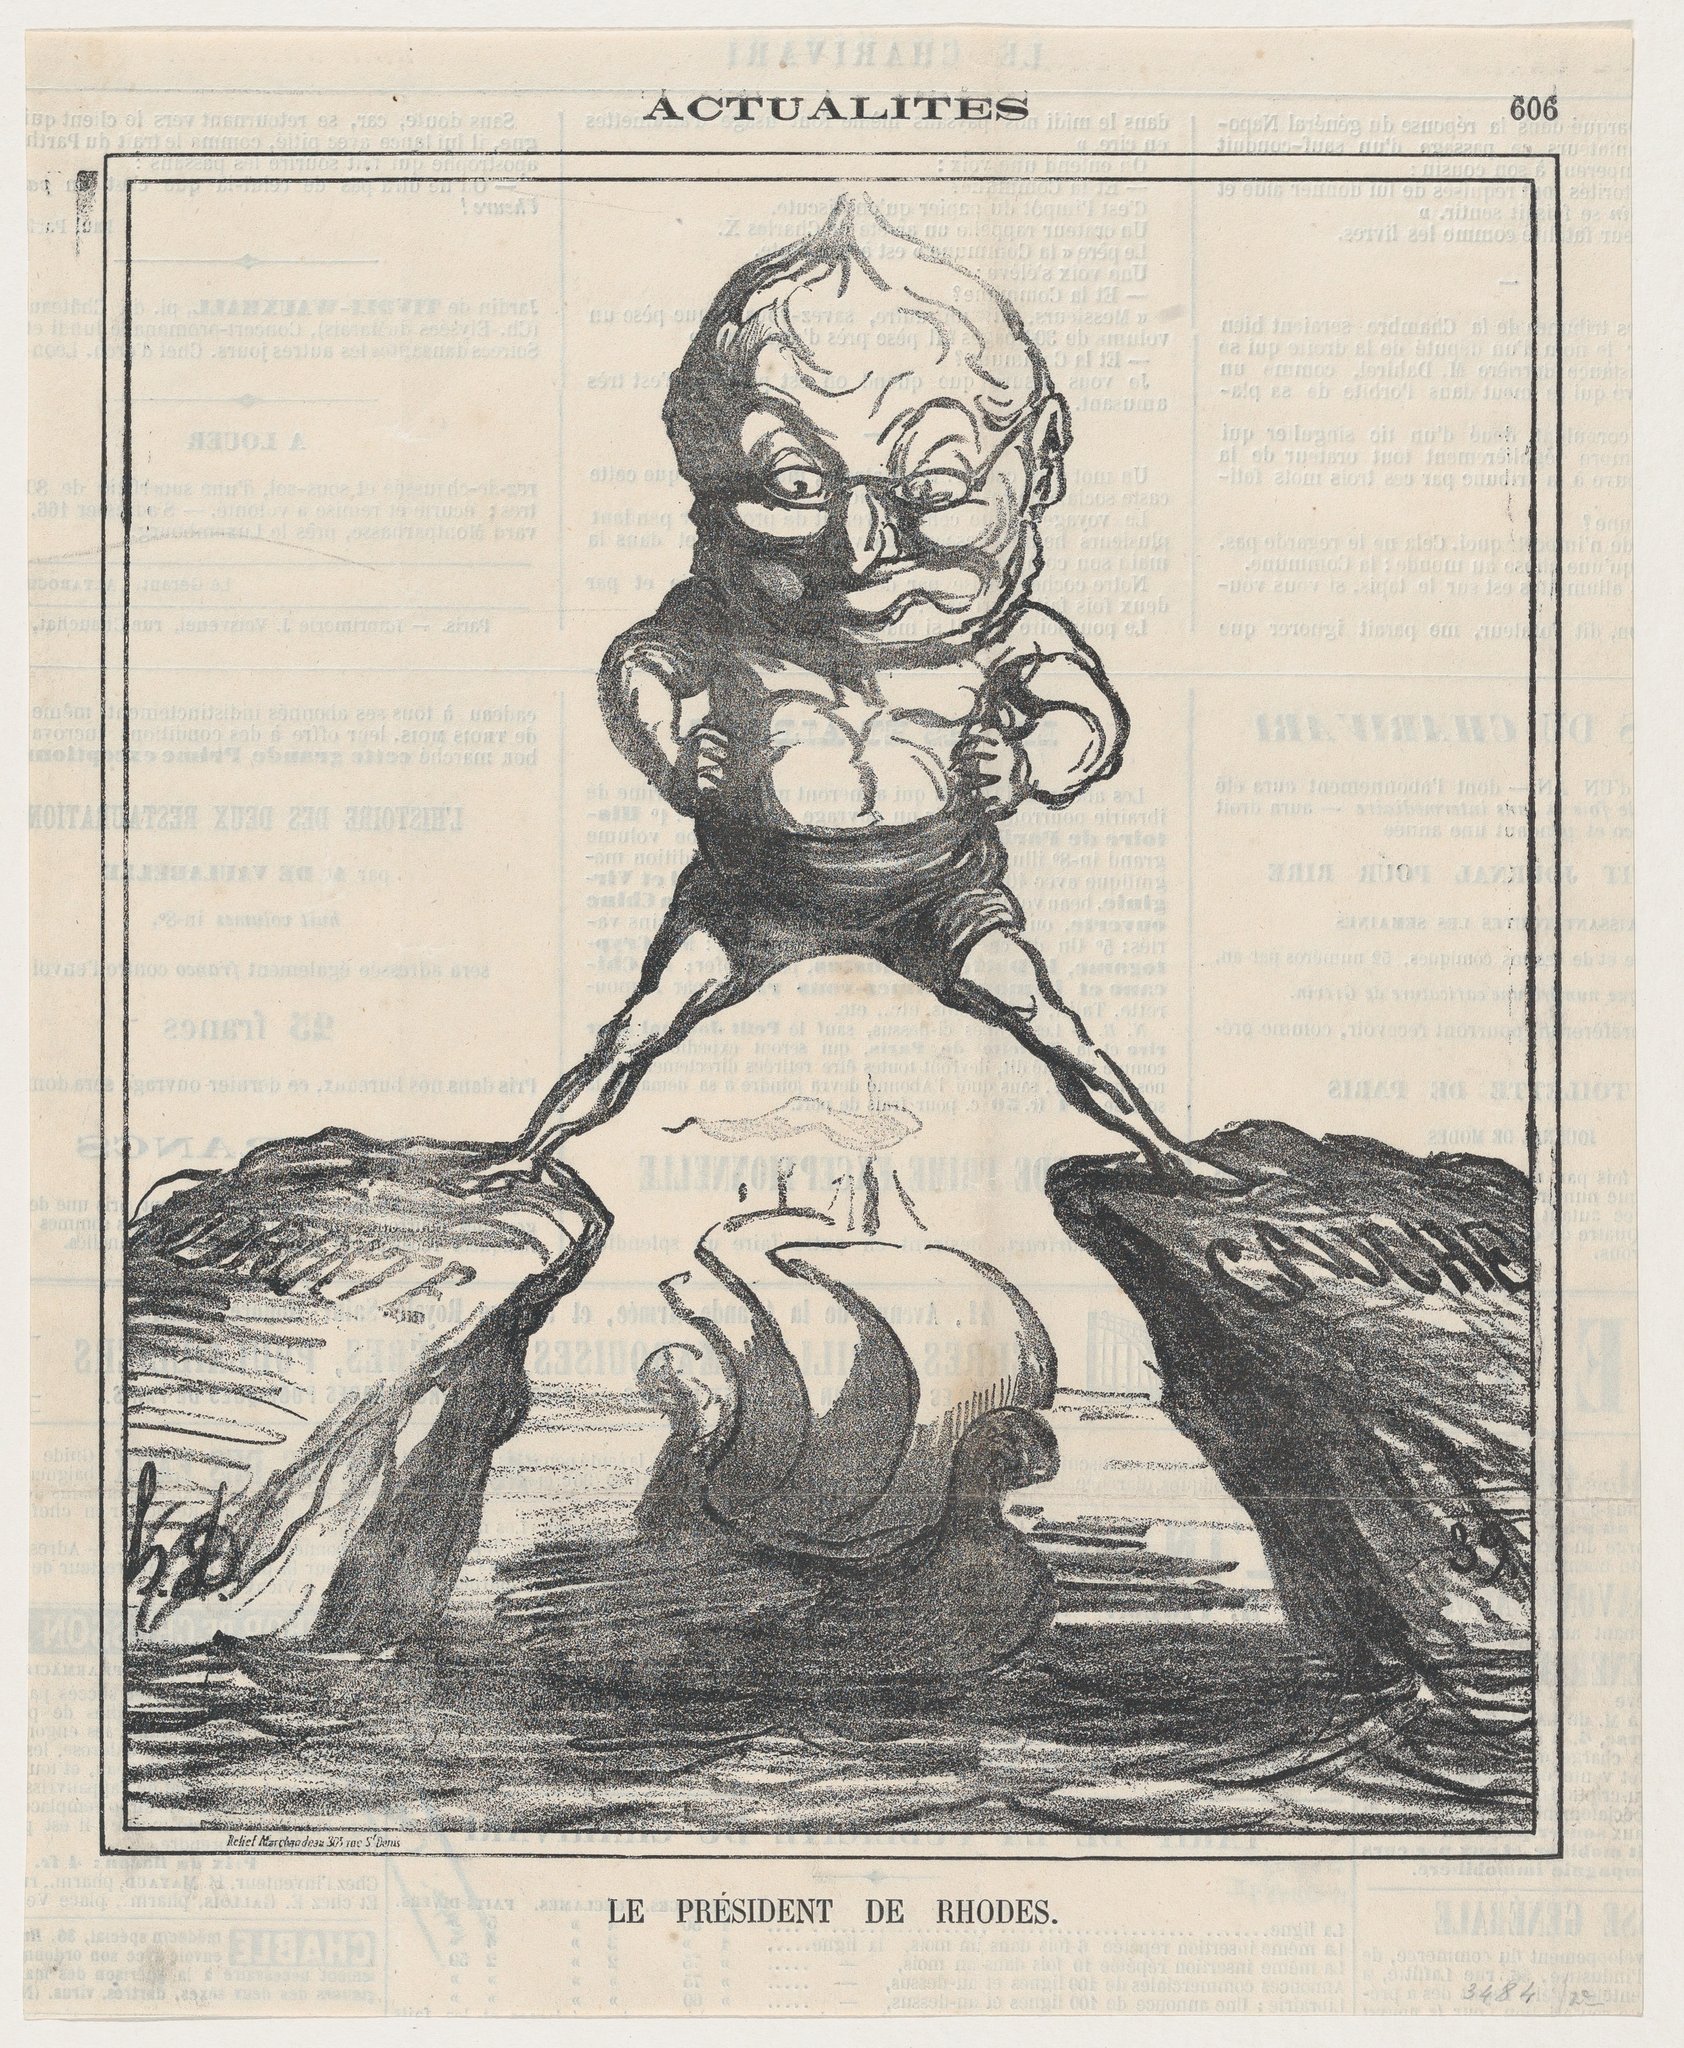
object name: print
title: The President of Rhodes, from "News of the day"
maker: honoré daumier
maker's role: artist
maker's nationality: french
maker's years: 1808-1879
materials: paper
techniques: lithograph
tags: men